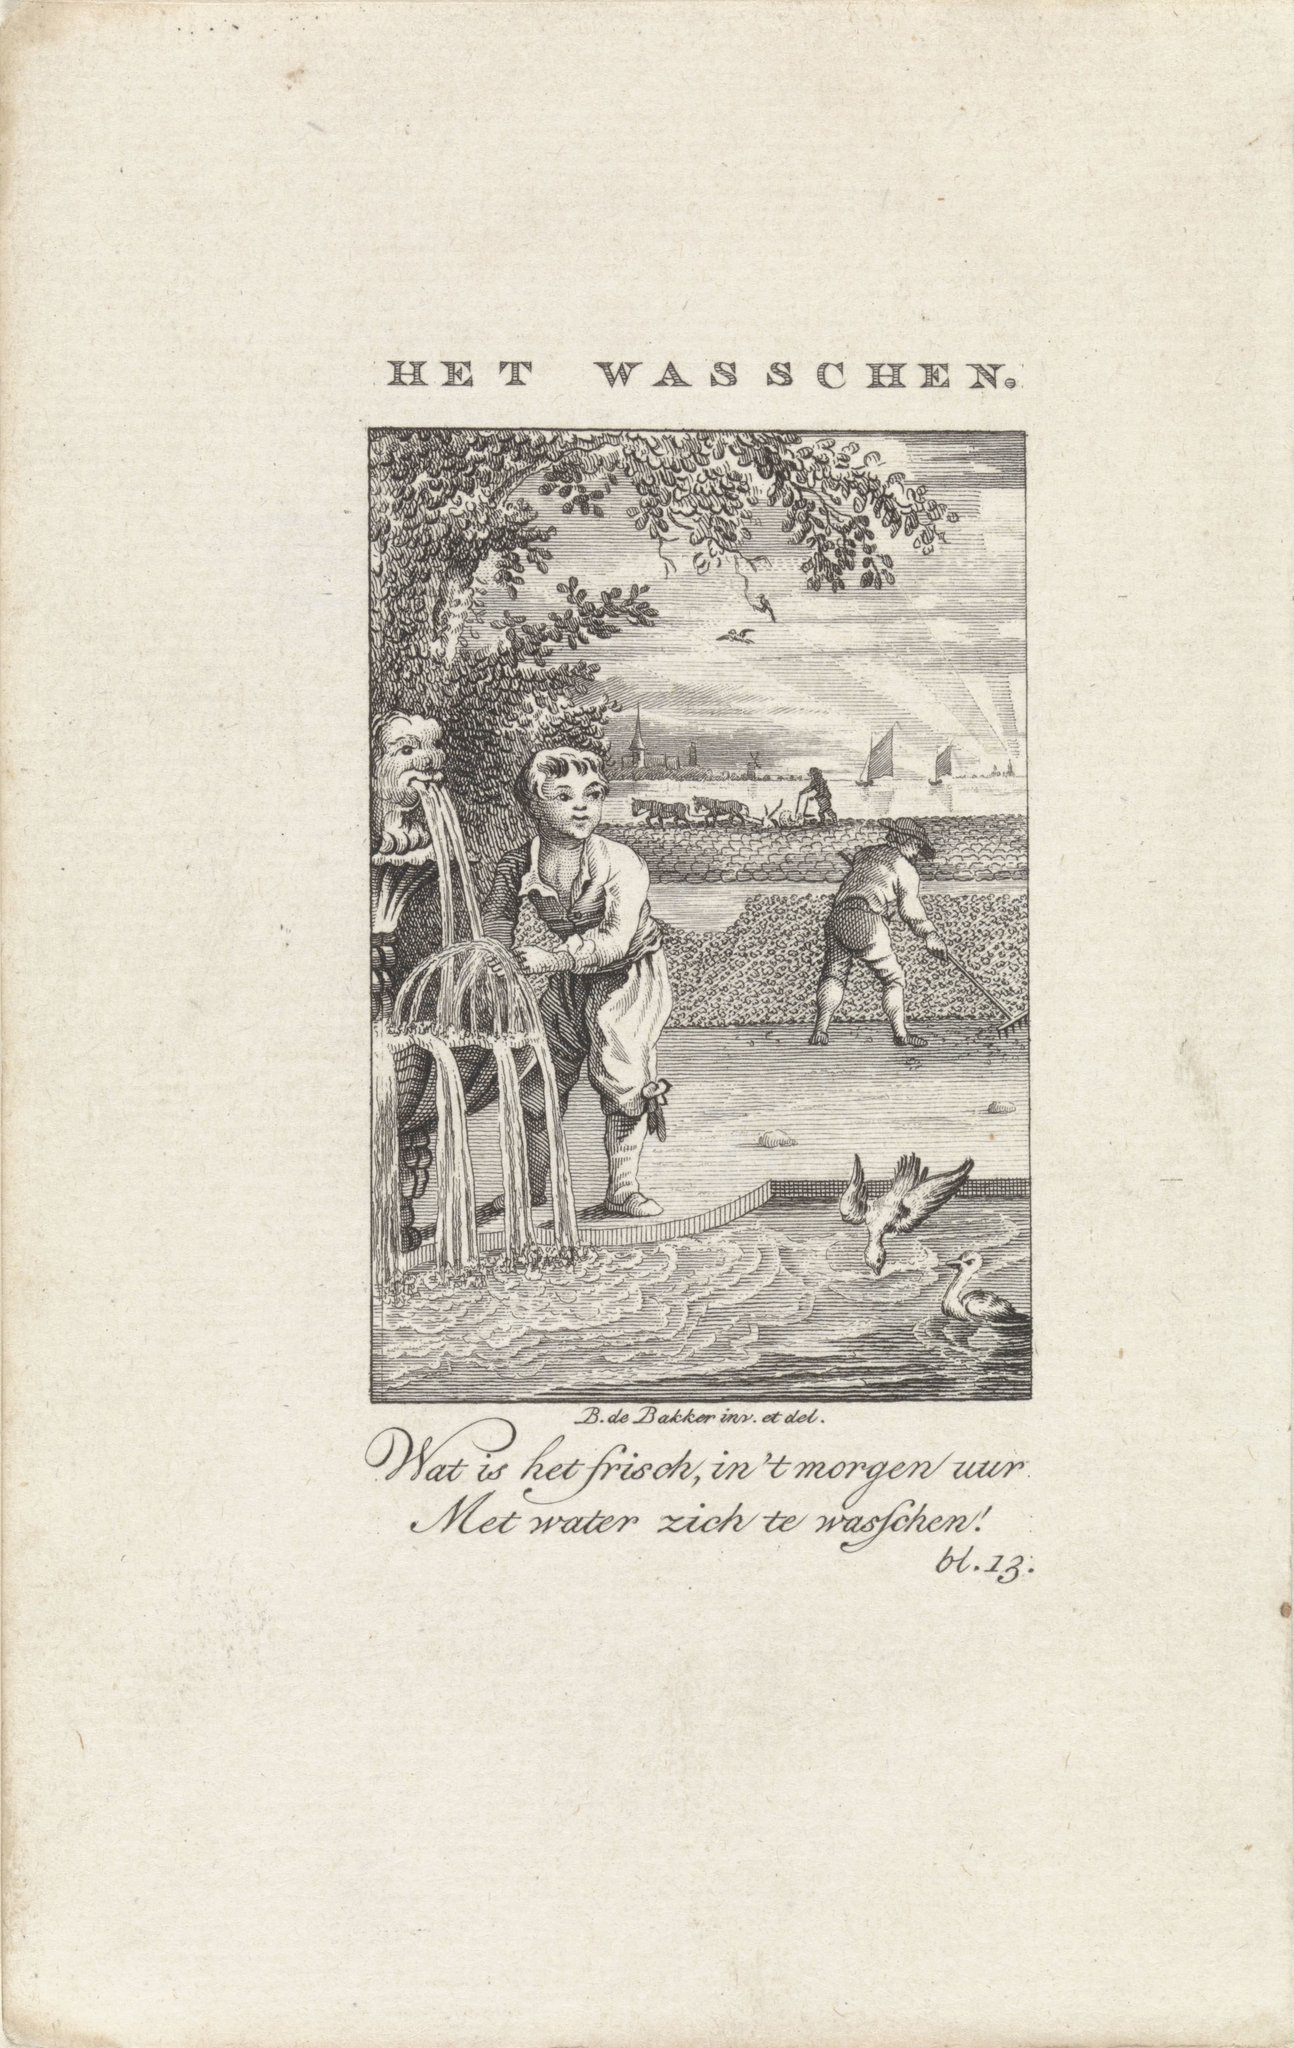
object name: print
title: Het wasschen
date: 1789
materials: paper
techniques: engraving, etching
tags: child, washing and bathing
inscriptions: collector's mark: Lugt 2760, collector's mark: Lugt 2228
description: Prent uit: Hazeu, Johannes Cornelisz., Kinderpligt en zinnebeelden, Willem van Vliet (uitgever), Amsterdam 1789